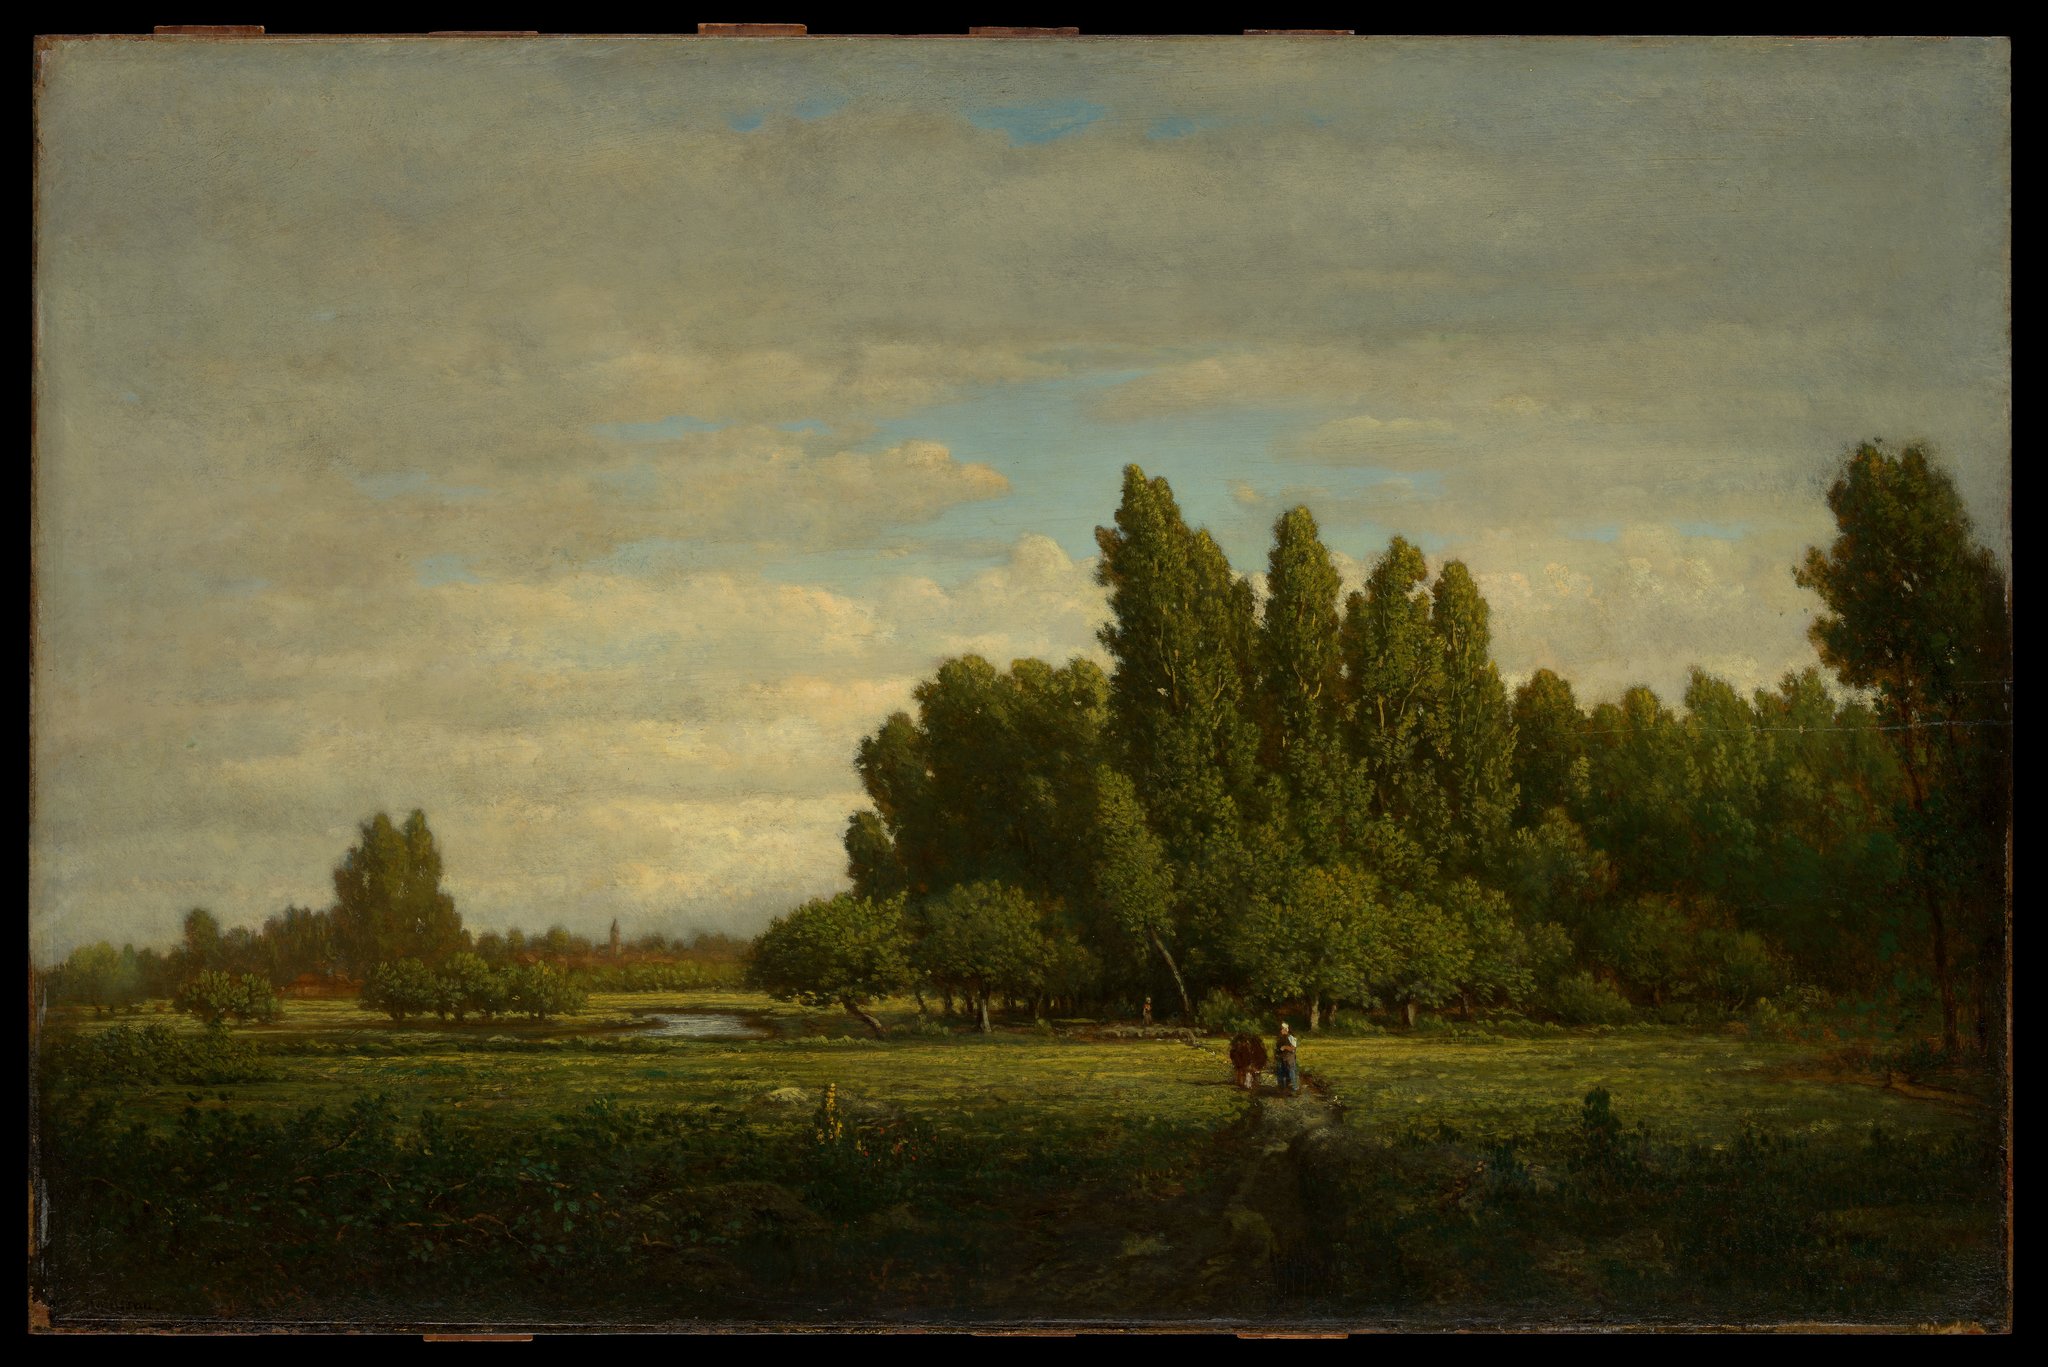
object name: painting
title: A Meadow Bordered by Trees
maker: théodore rousseau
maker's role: artist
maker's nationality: french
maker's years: 1812-1867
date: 1845-1860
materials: oil, wood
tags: landscapes